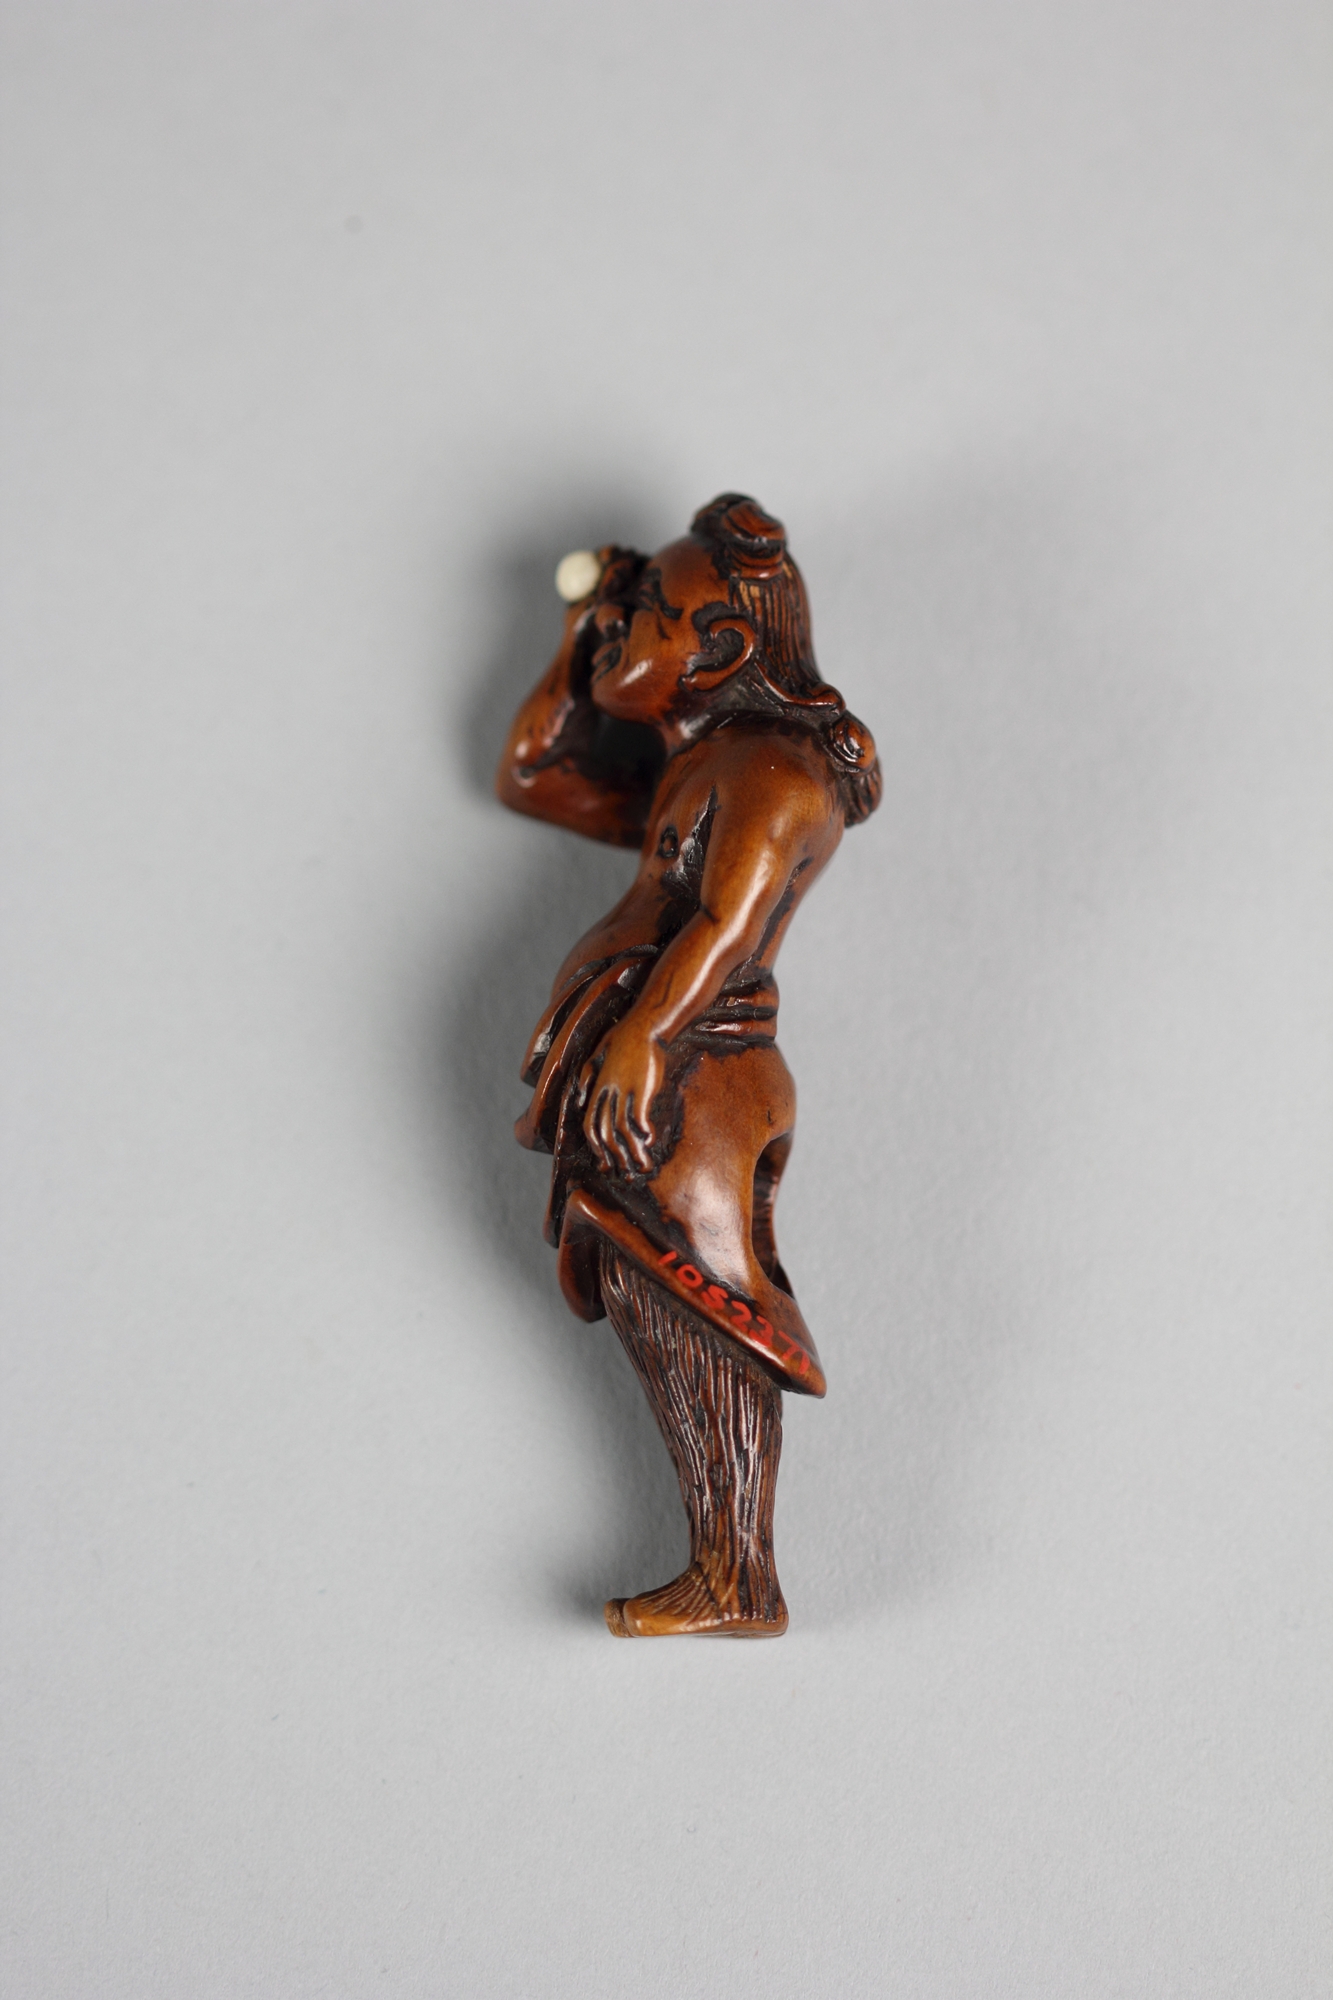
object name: netsuke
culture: japanese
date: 1701-1800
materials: wood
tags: men